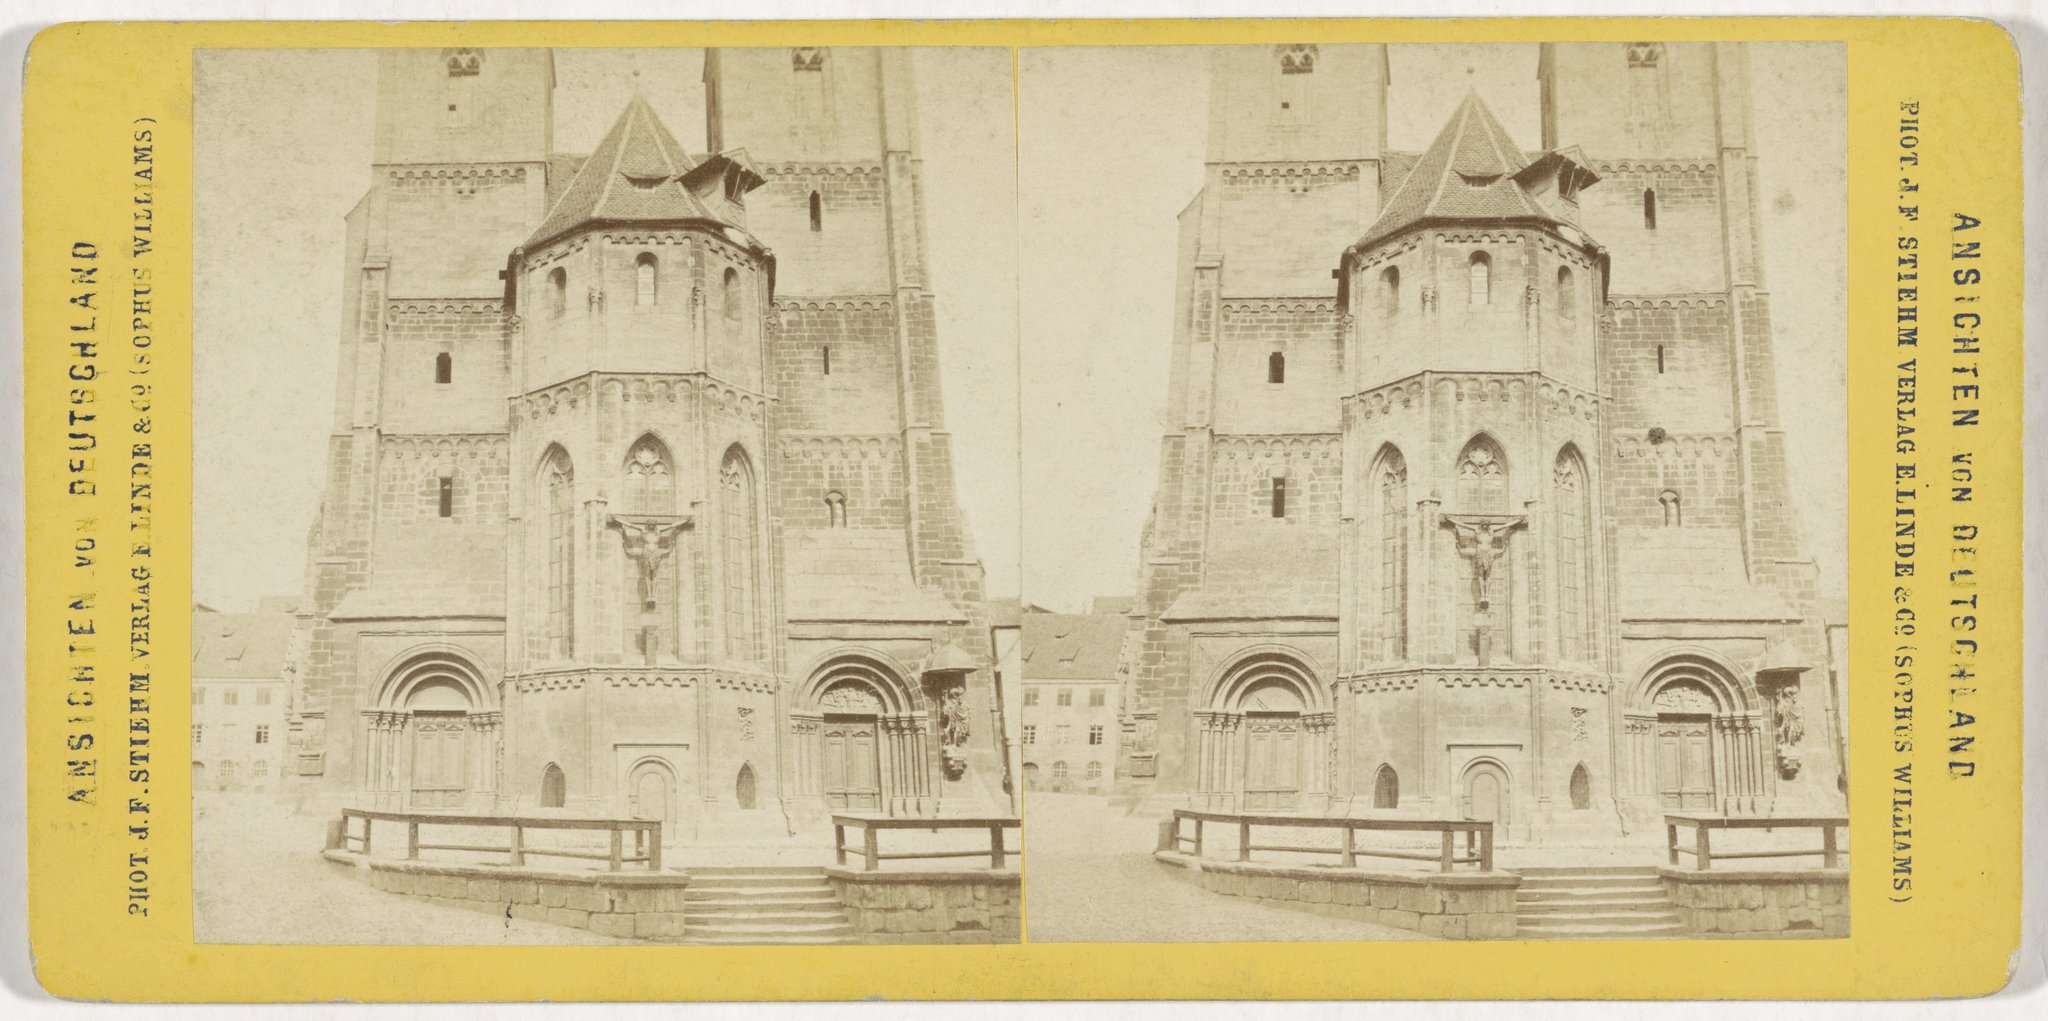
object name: stereograph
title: Ansichten von Deutschland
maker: johann friedrich stiehm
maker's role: fotograaf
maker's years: 1826-1902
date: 1868-1900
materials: cardboard, paper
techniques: albumen print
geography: nuremberg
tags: parts of church exterior and annexes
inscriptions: number: ‘No. 4.’